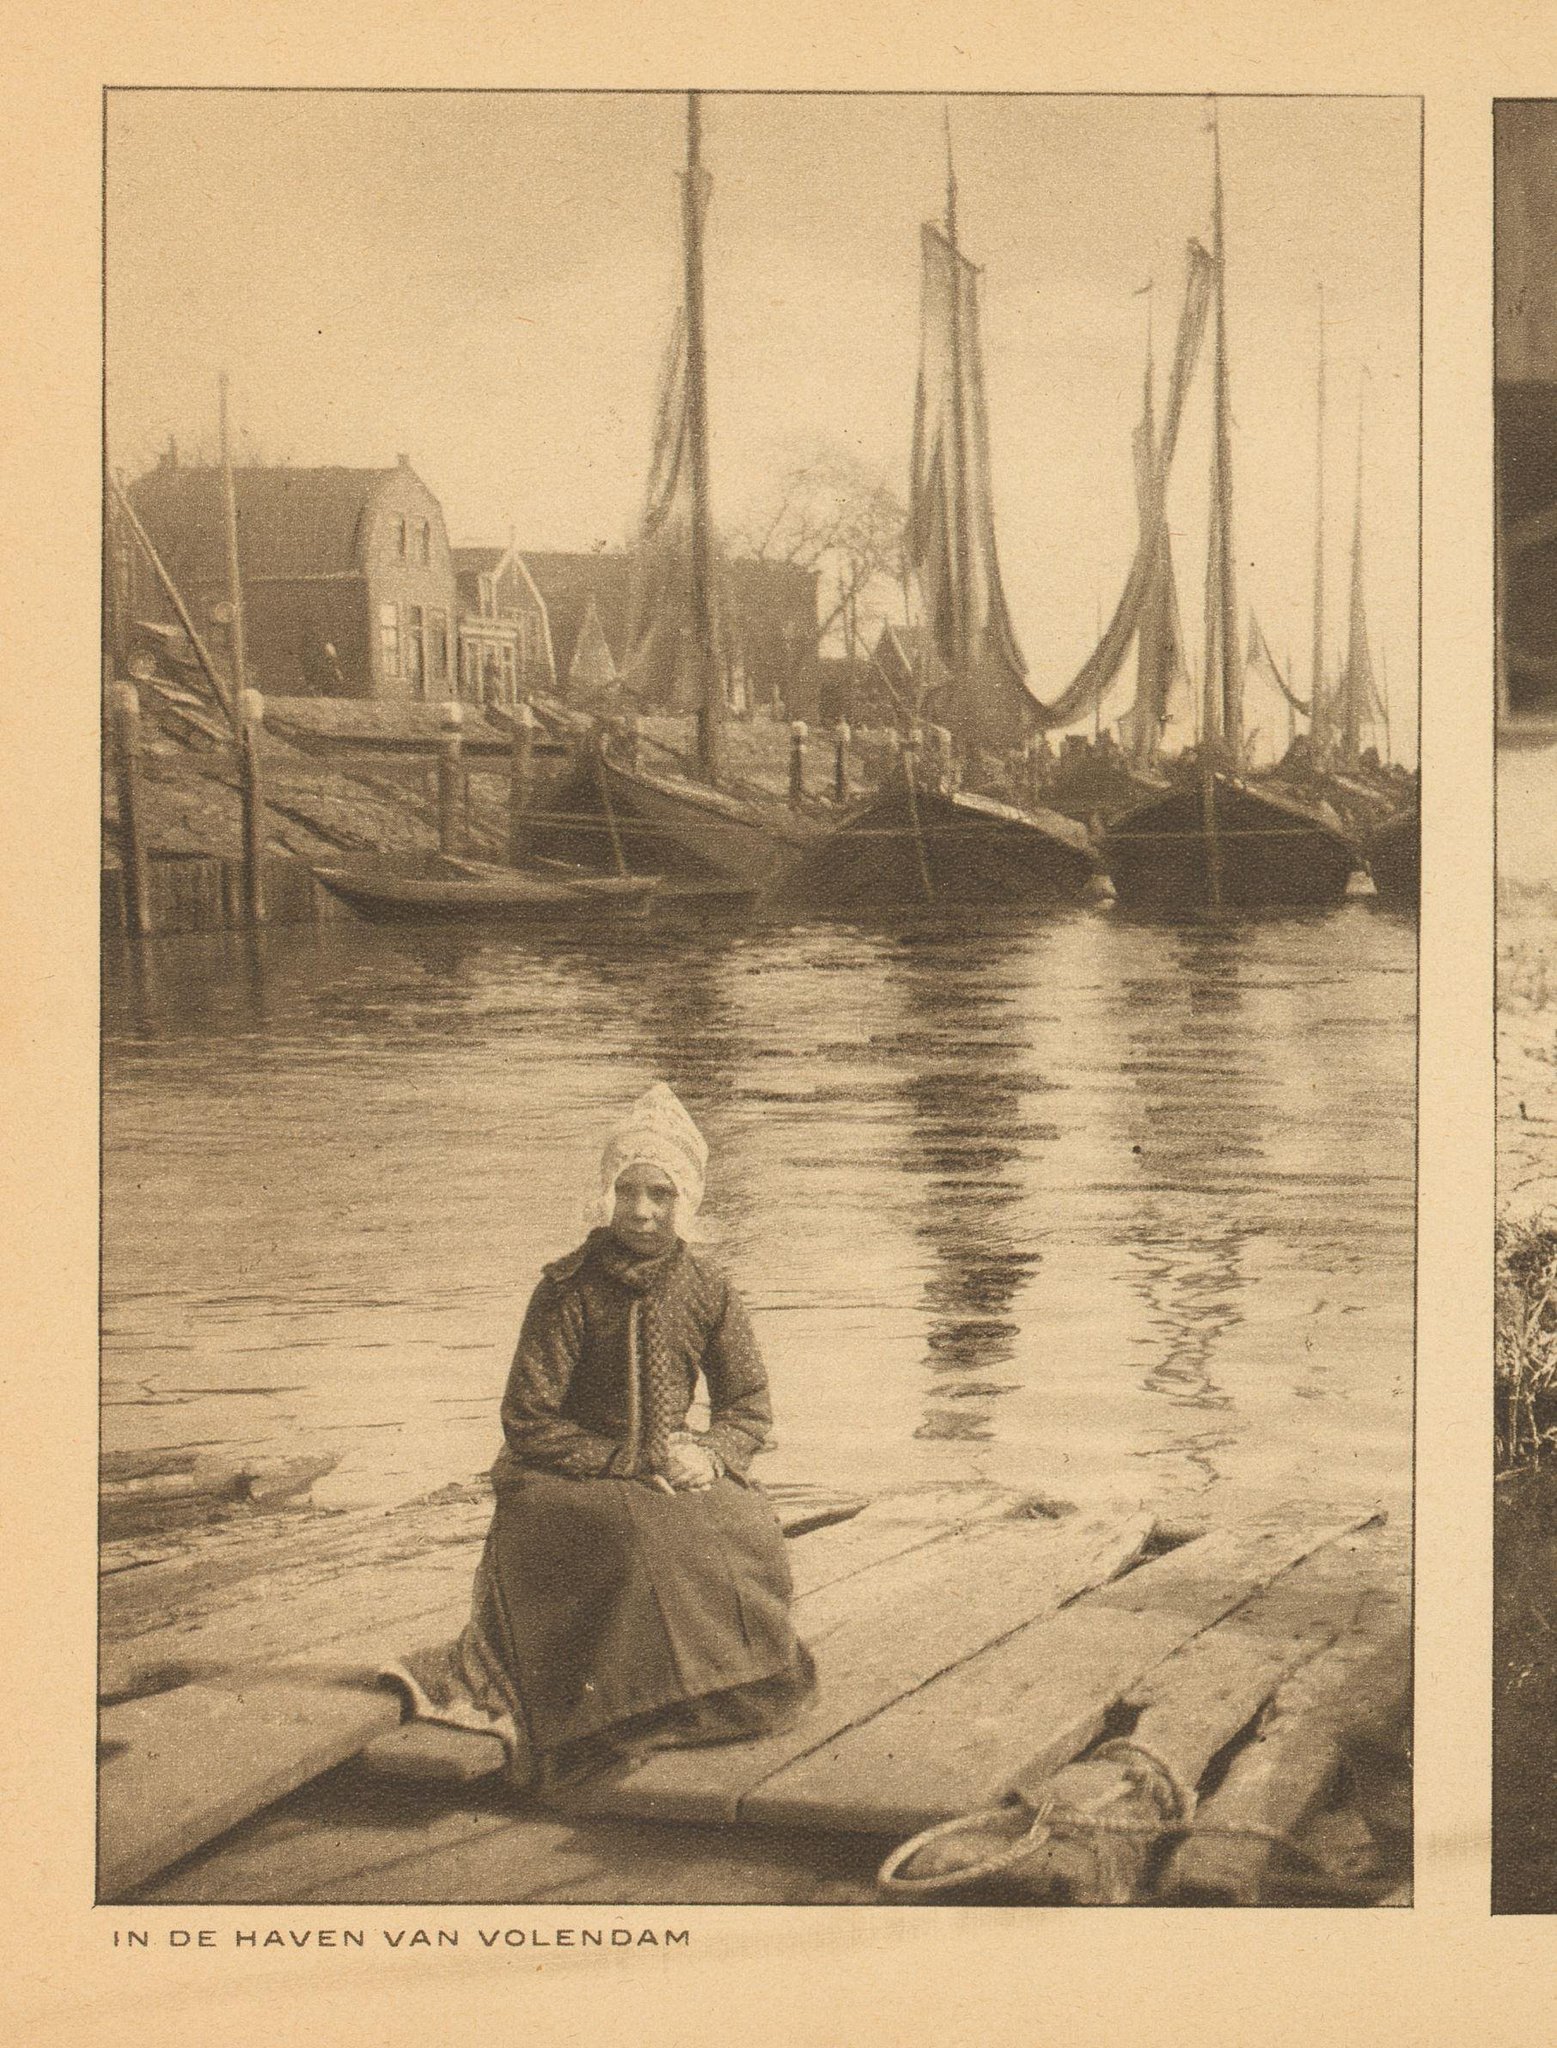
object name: photomechanical print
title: Meisje in klederdracht op de kade in de haven van Volendam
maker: Anonymous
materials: paper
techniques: rotogravure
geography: leiden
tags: harbour, girl (child between toddler and youth), folk costume, regional costume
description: Deze prent maakt deel uit van een album.